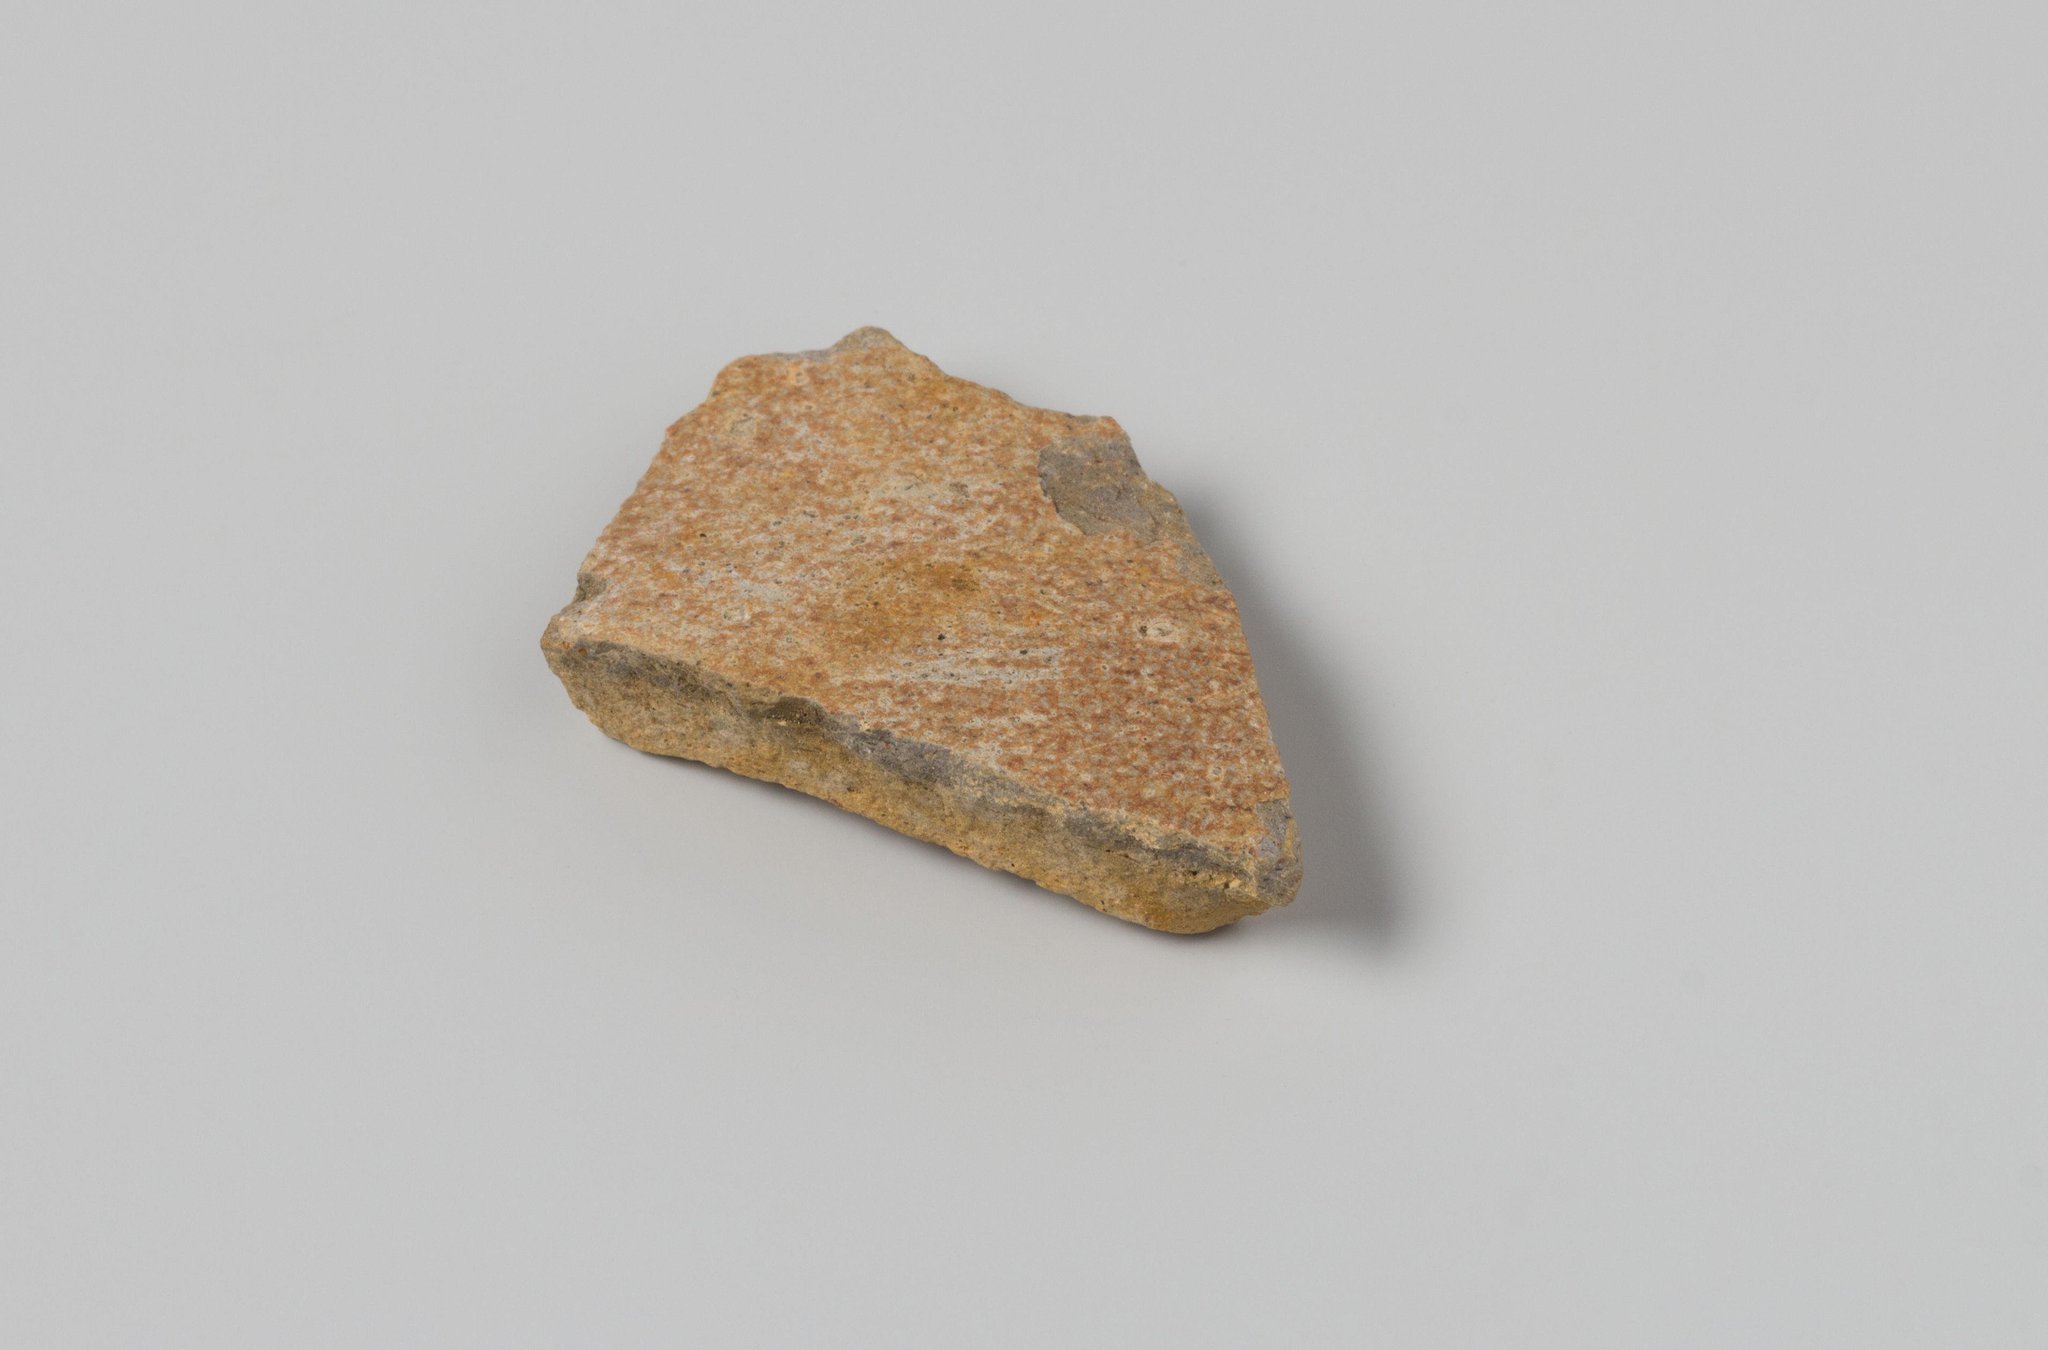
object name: sherd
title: Scherf van een kan uit het wrak van de Oost-Indiëvaarder Hollandia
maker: Anonymous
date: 1700-1743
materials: stoneware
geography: westerwald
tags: verenigde oostindische compagnie, hollandia (schip), annet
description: Stoneware, Rhenish, Westerwald, jug; fragm of body, sim. NG 1980-27H2615.